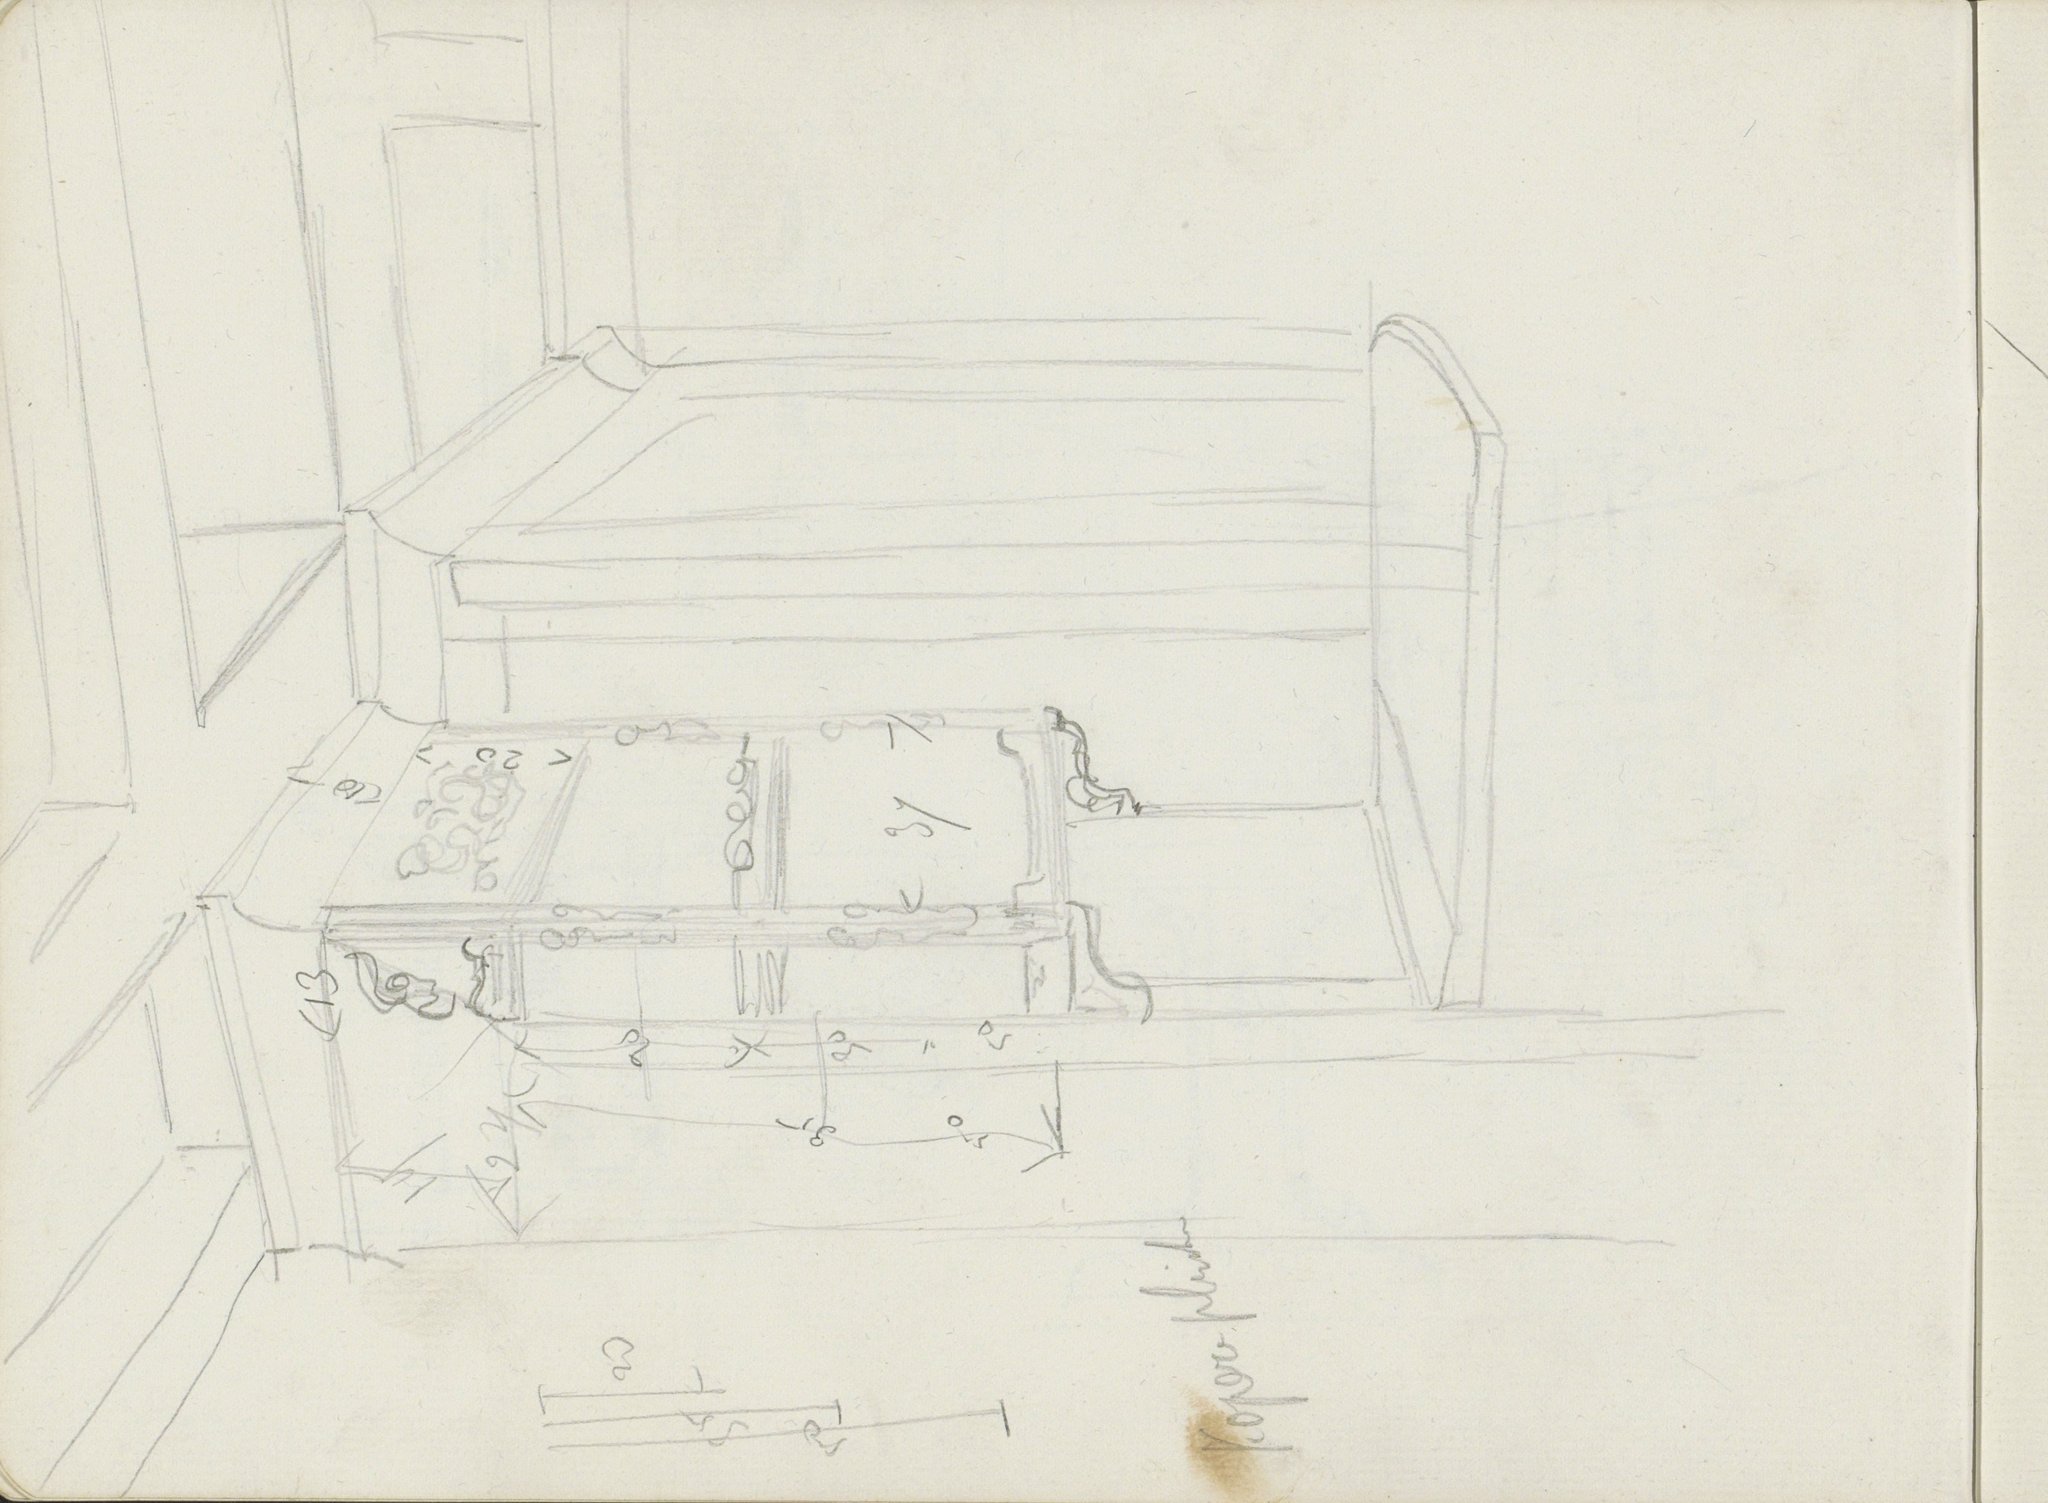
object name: sketchbook leaf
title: Wand en plafond van een interieur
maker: carel adolph lion cachet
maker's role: draughtsman, print maker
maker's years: 1864-1945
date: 1905-1910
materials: paper, pencil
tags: interior ~ representation of a building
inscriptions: annotation: ‘koper pl[...]’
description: Blad 14 verso uit een schetsboek met 27 bladen.